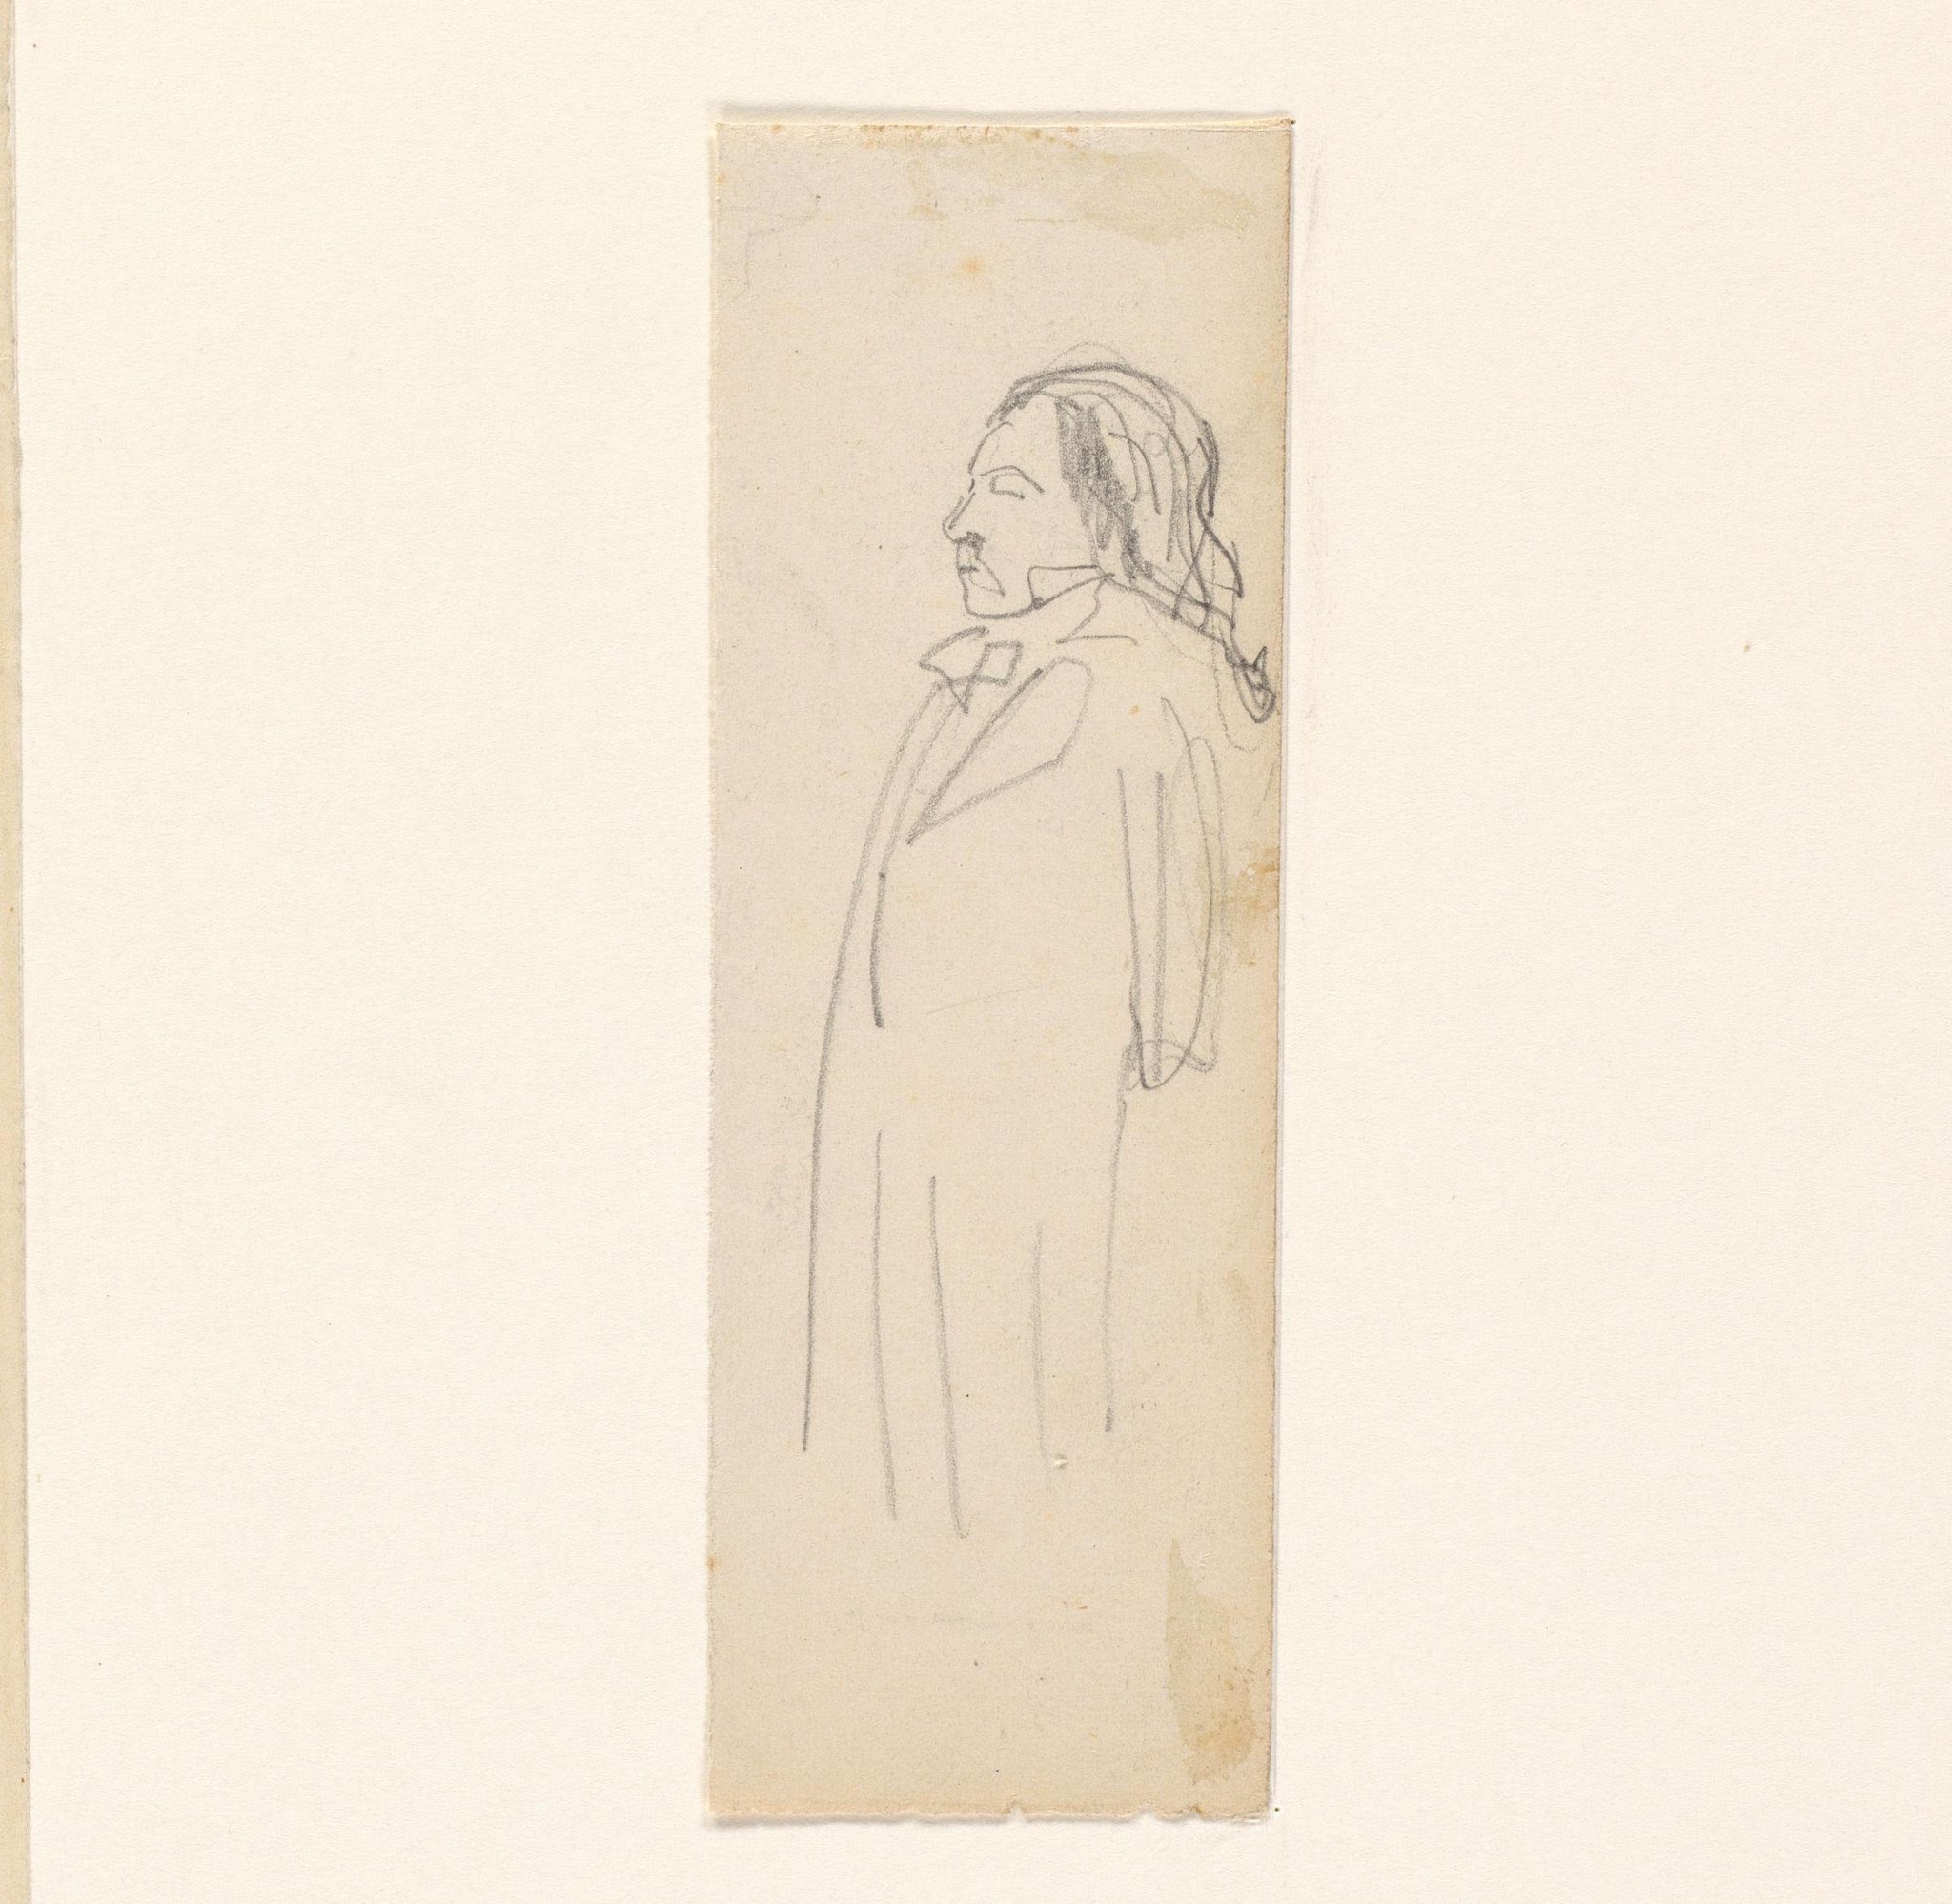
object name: drawing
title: Man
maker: august allebé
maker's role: draughtsman, print maker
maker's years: 1838-1927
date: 1848-1927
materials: paper, pencil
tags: the (nude) human figure; 'corpo humano' (ripa), piece of sculpture, reproduction of a piece of sculpture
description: Studie van een beeldhouwwerk in het Louvre.